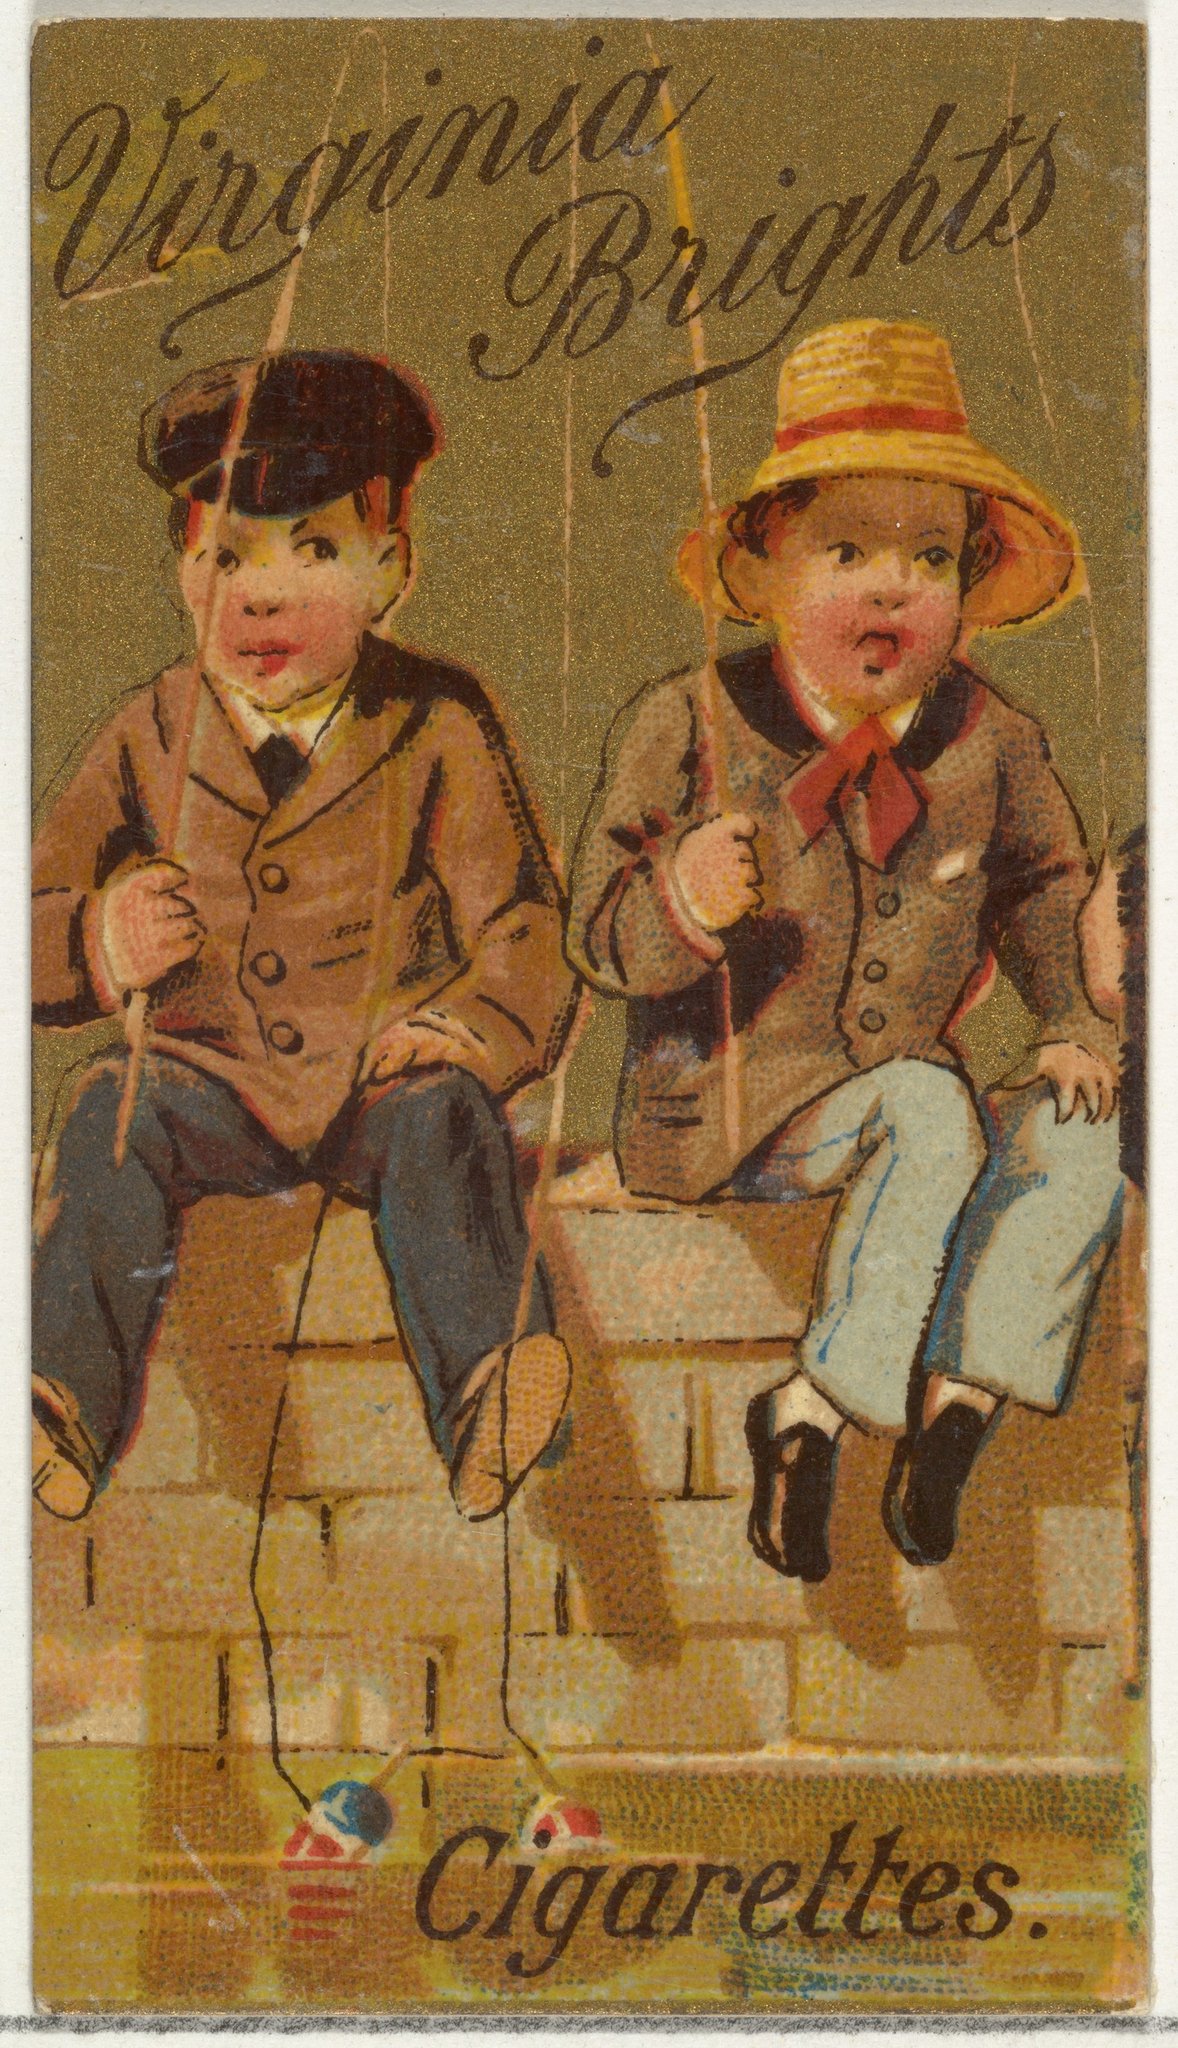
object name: print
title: From the Girls and Children series (N64) promoting Virginia Brights Cigarettes for Allen & Ginter brand tobacco products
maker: allen & ginter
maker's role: publisher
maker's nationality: american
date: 1886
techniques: color lithograph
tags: boys